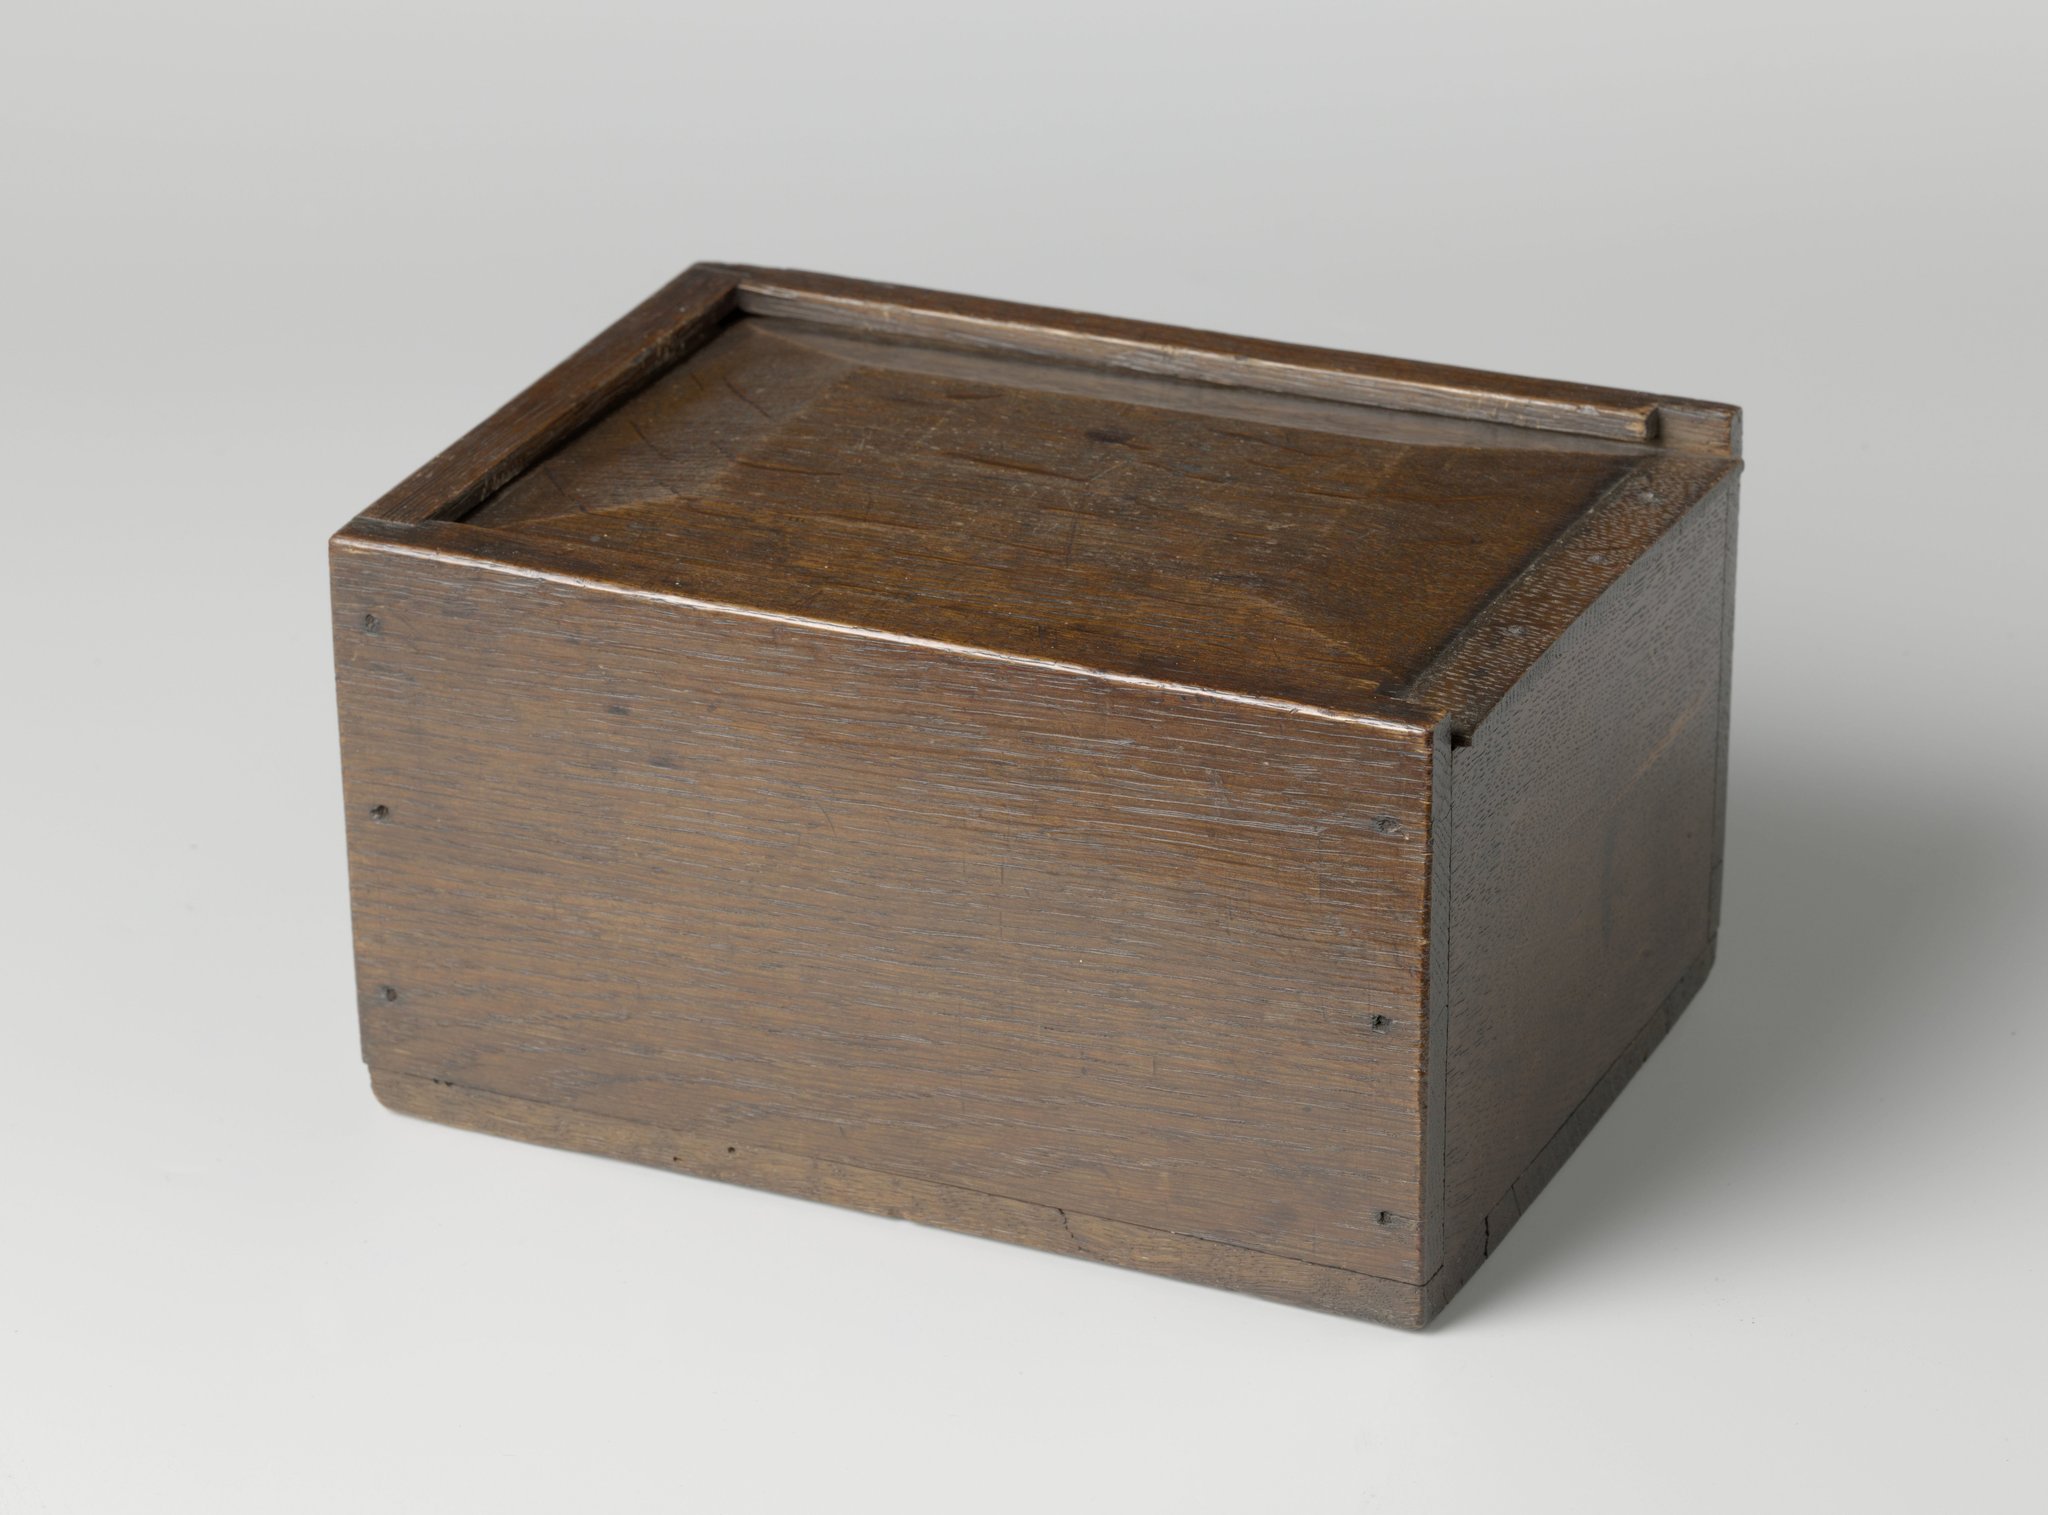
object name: furniture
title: Kist met zes messing muziekrollen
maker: Anonymous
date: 1715-1725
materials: brass, wood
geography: netherlands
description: Eikenhouten kist waarin zes messing muziekrollen zijn geborgen, behorende bij een stand horloge, geheel belijmd in de zogenaamde Boulle-techniek.